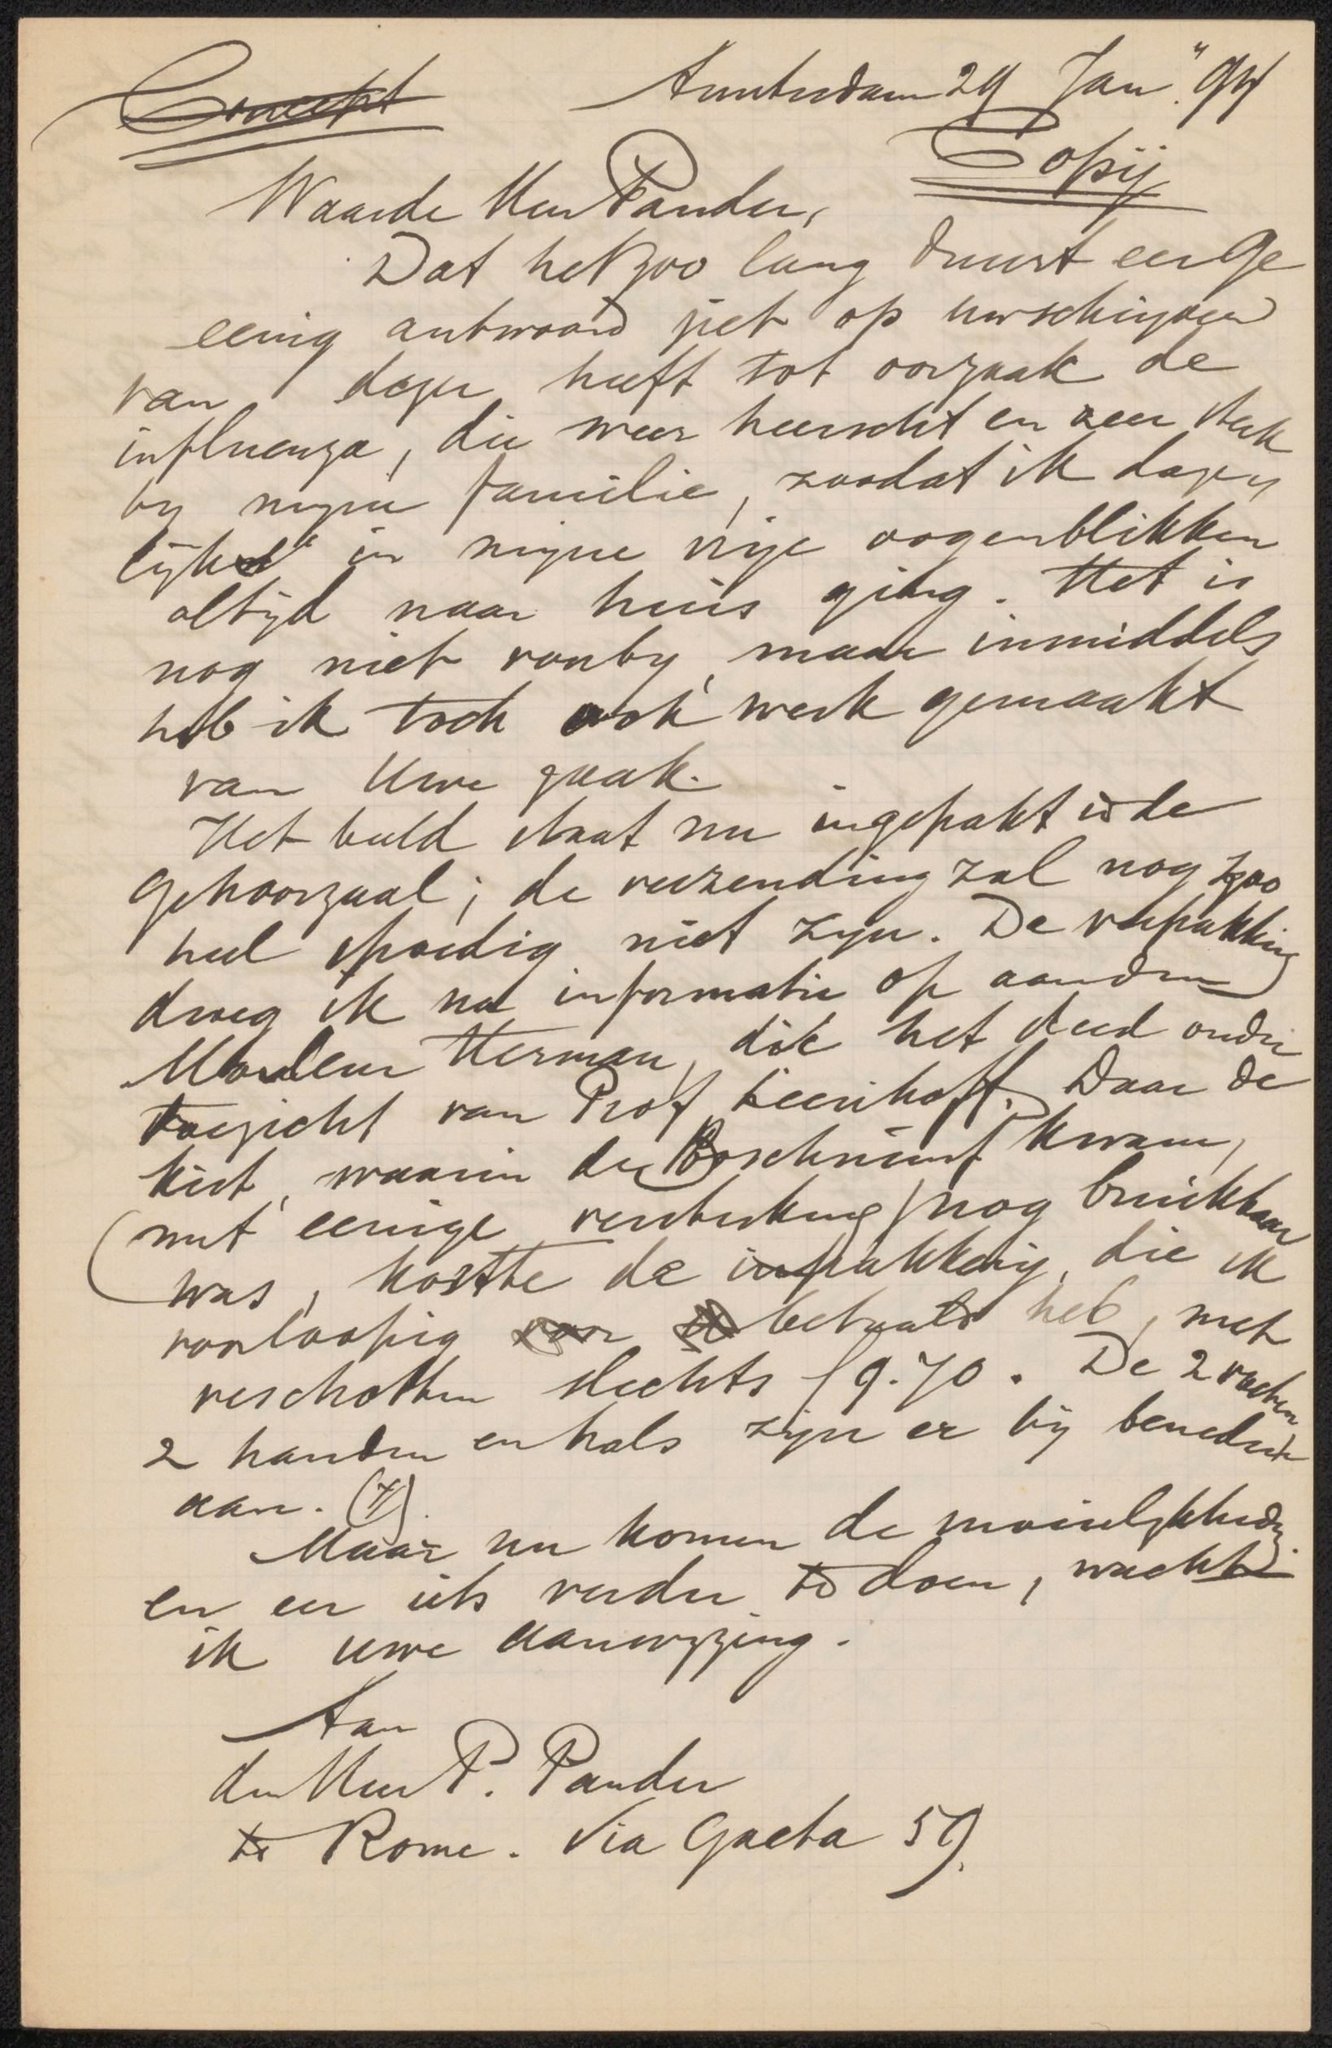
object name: letter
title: Brief aan Pier Pander, brief aan Johann Georg van Caspel en brief aan mevrouw Bogaert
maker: august allebé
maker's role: draughtsman, print maker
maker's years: 1838-1927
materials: ink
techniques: pen, writing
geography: amsterdam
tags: painter, conservator, henri goovaerts, johann georg van caspel, ferdinand leenhoff, rome, draughtsman, designer, sculptor, pier pander, family life, sculpture, education, tuition of the artist (in general), diseases, money